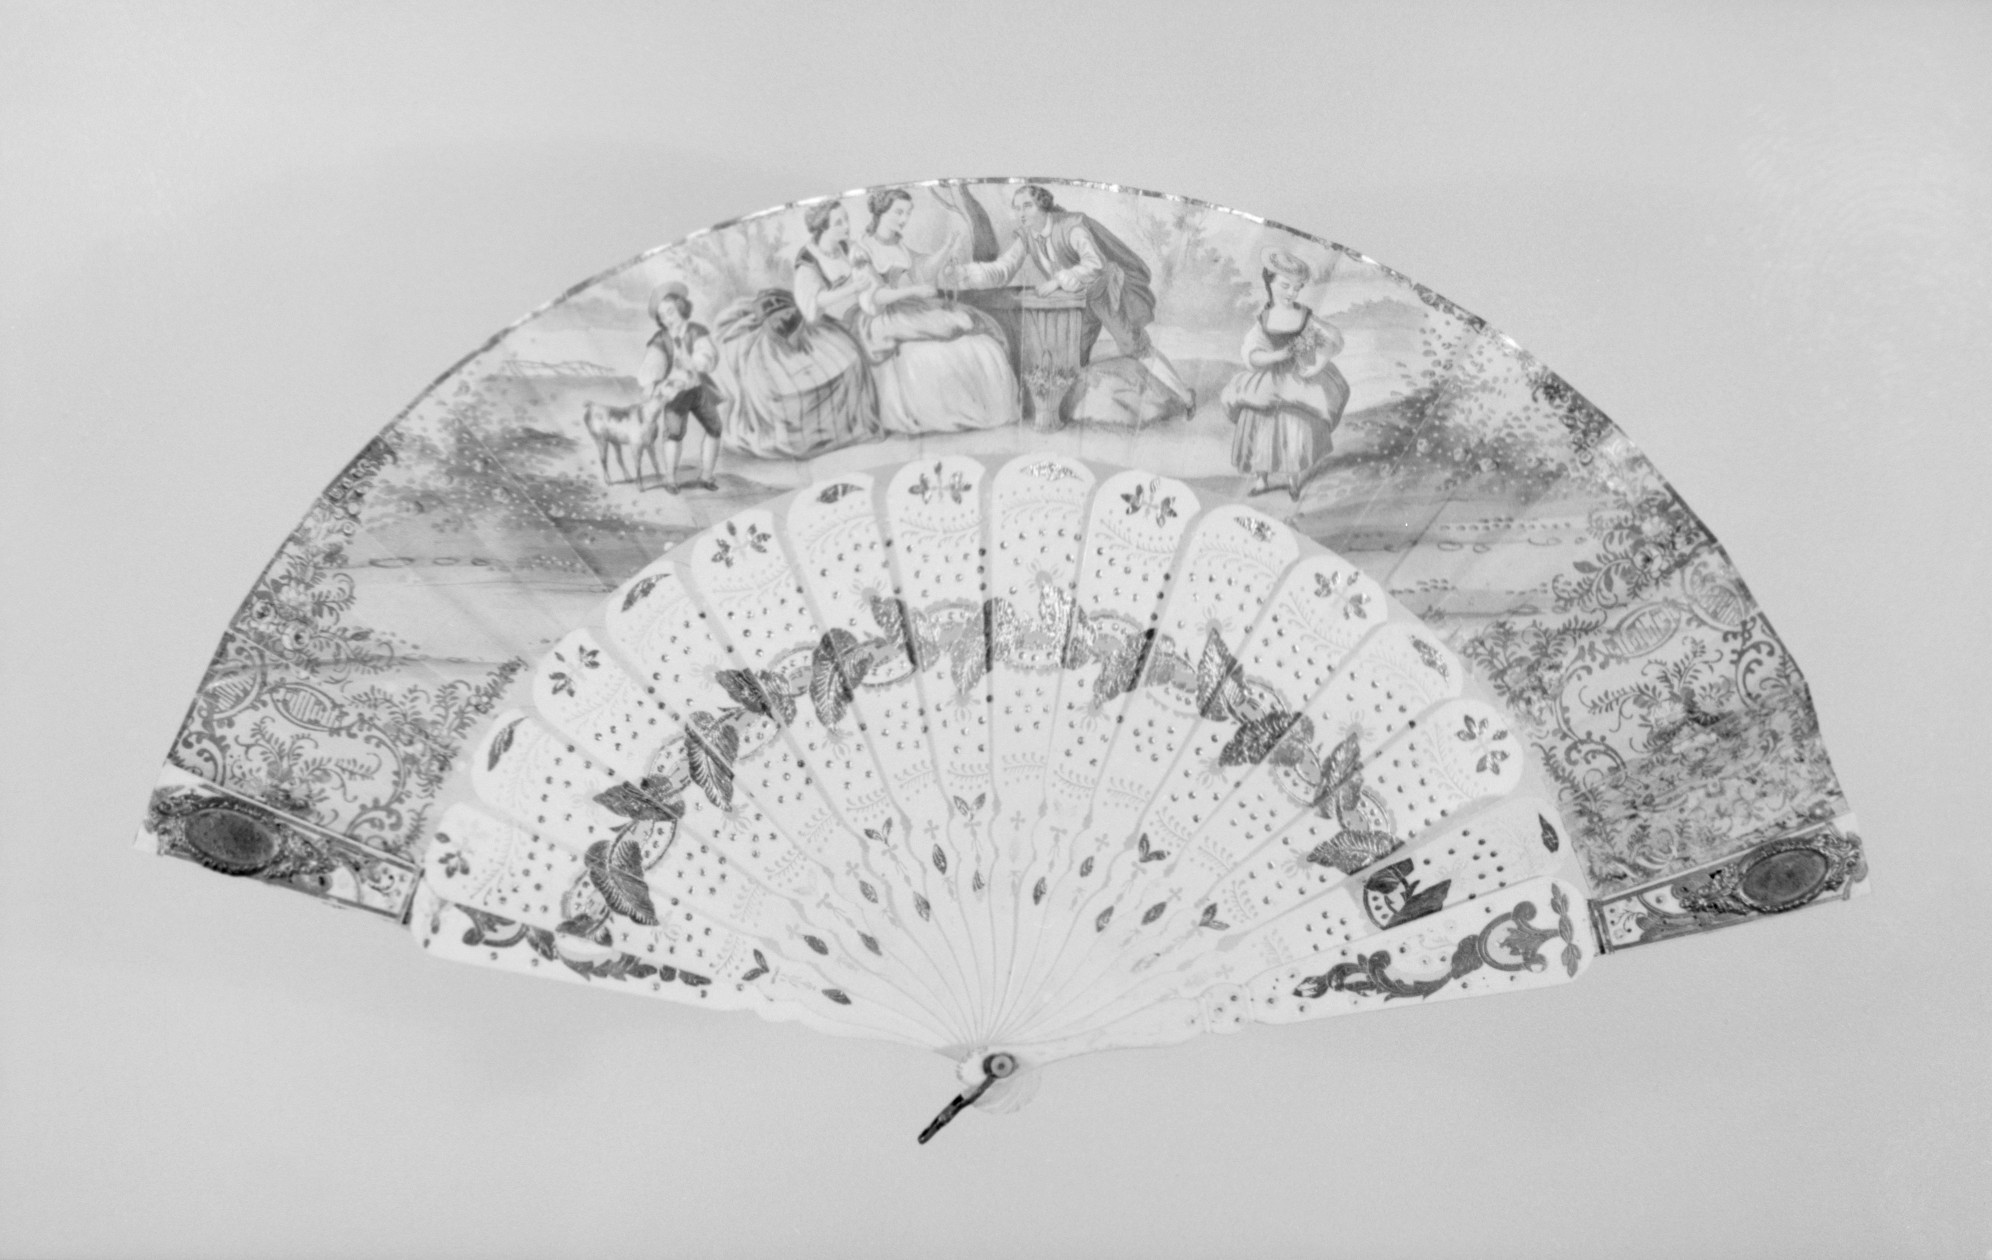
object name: fan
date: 1834-1866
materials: gilt, gold foil, ivory, metal, mother of pearl, paint, paper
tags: animals,boys,girls,men,women